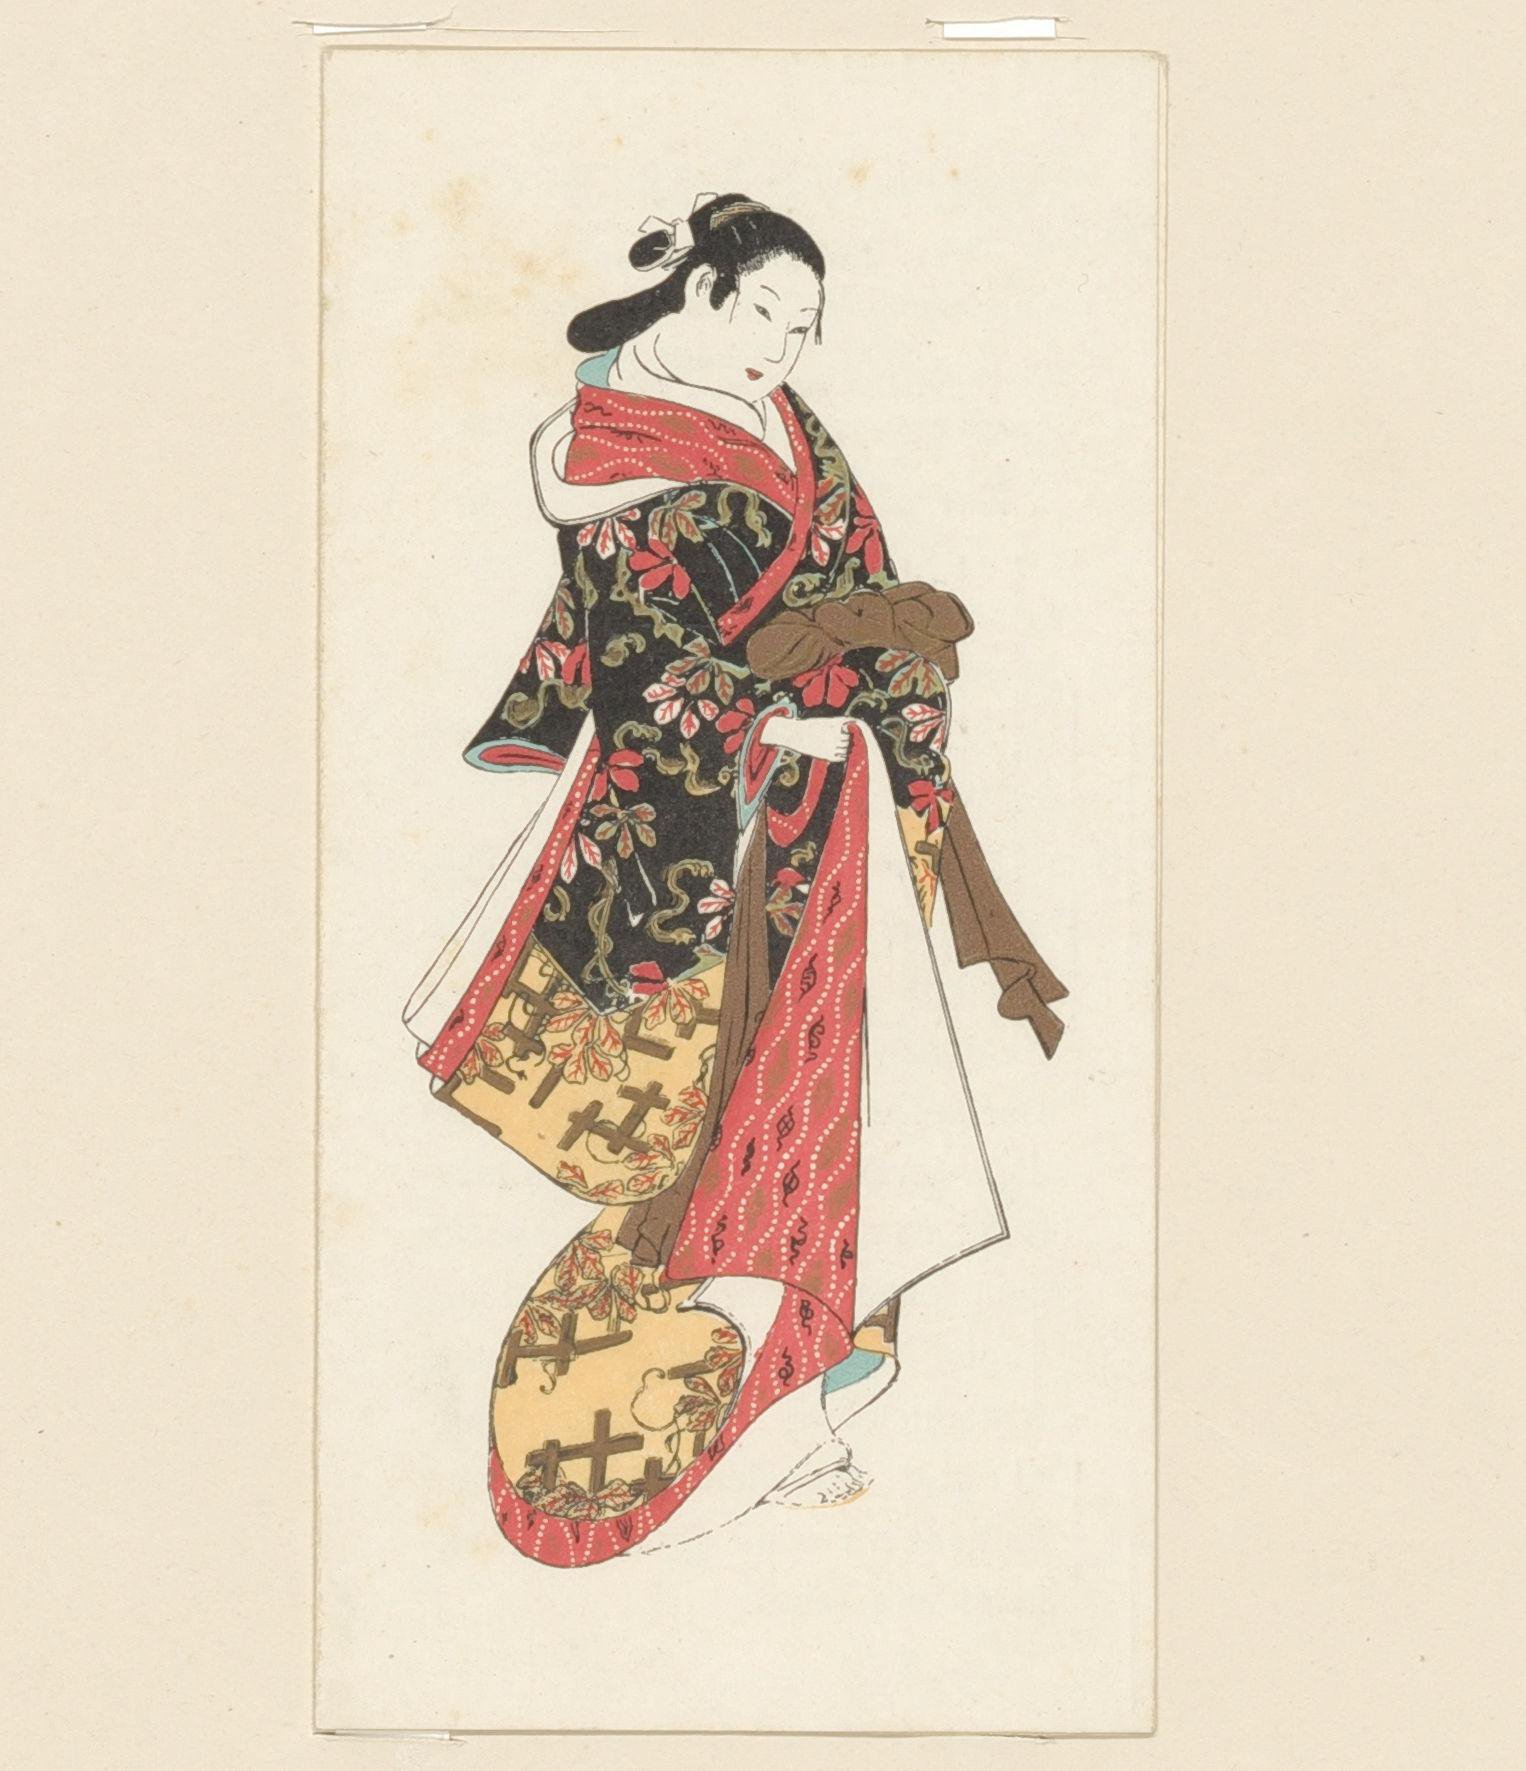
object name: photomechanical print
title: Vrouw in een kimono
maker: Anonymous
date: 1900-1949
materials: paint, paper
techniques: letterpress printing, printing block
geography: netherlands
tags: party clothes, festive attire, child between toddler and youth (of undetermined sex), the hague, haarlem, rotterdam, utrecht, nijmegen, amsterdam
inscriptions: collector's mark: Lugt 1641, stamp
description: Adreskaart van Van Veen & Co. Zij zijn importeurs van Japanse en Chinese artikelen. Zij hebben divers locaties in Amsterdam, Den Haag, Rotterdam, Nijmegen, Hilversum, Utrecht en Haarlem. Onderwerpsrubrieken binnen de Atlas Zeden en Gewoonten: Handel, nijverheid en verkeer, Koophandel, Veilingen, Makelaardij en Verzekeringswezen, Oude adreskaarten van winkels en fabrieken, reclame.